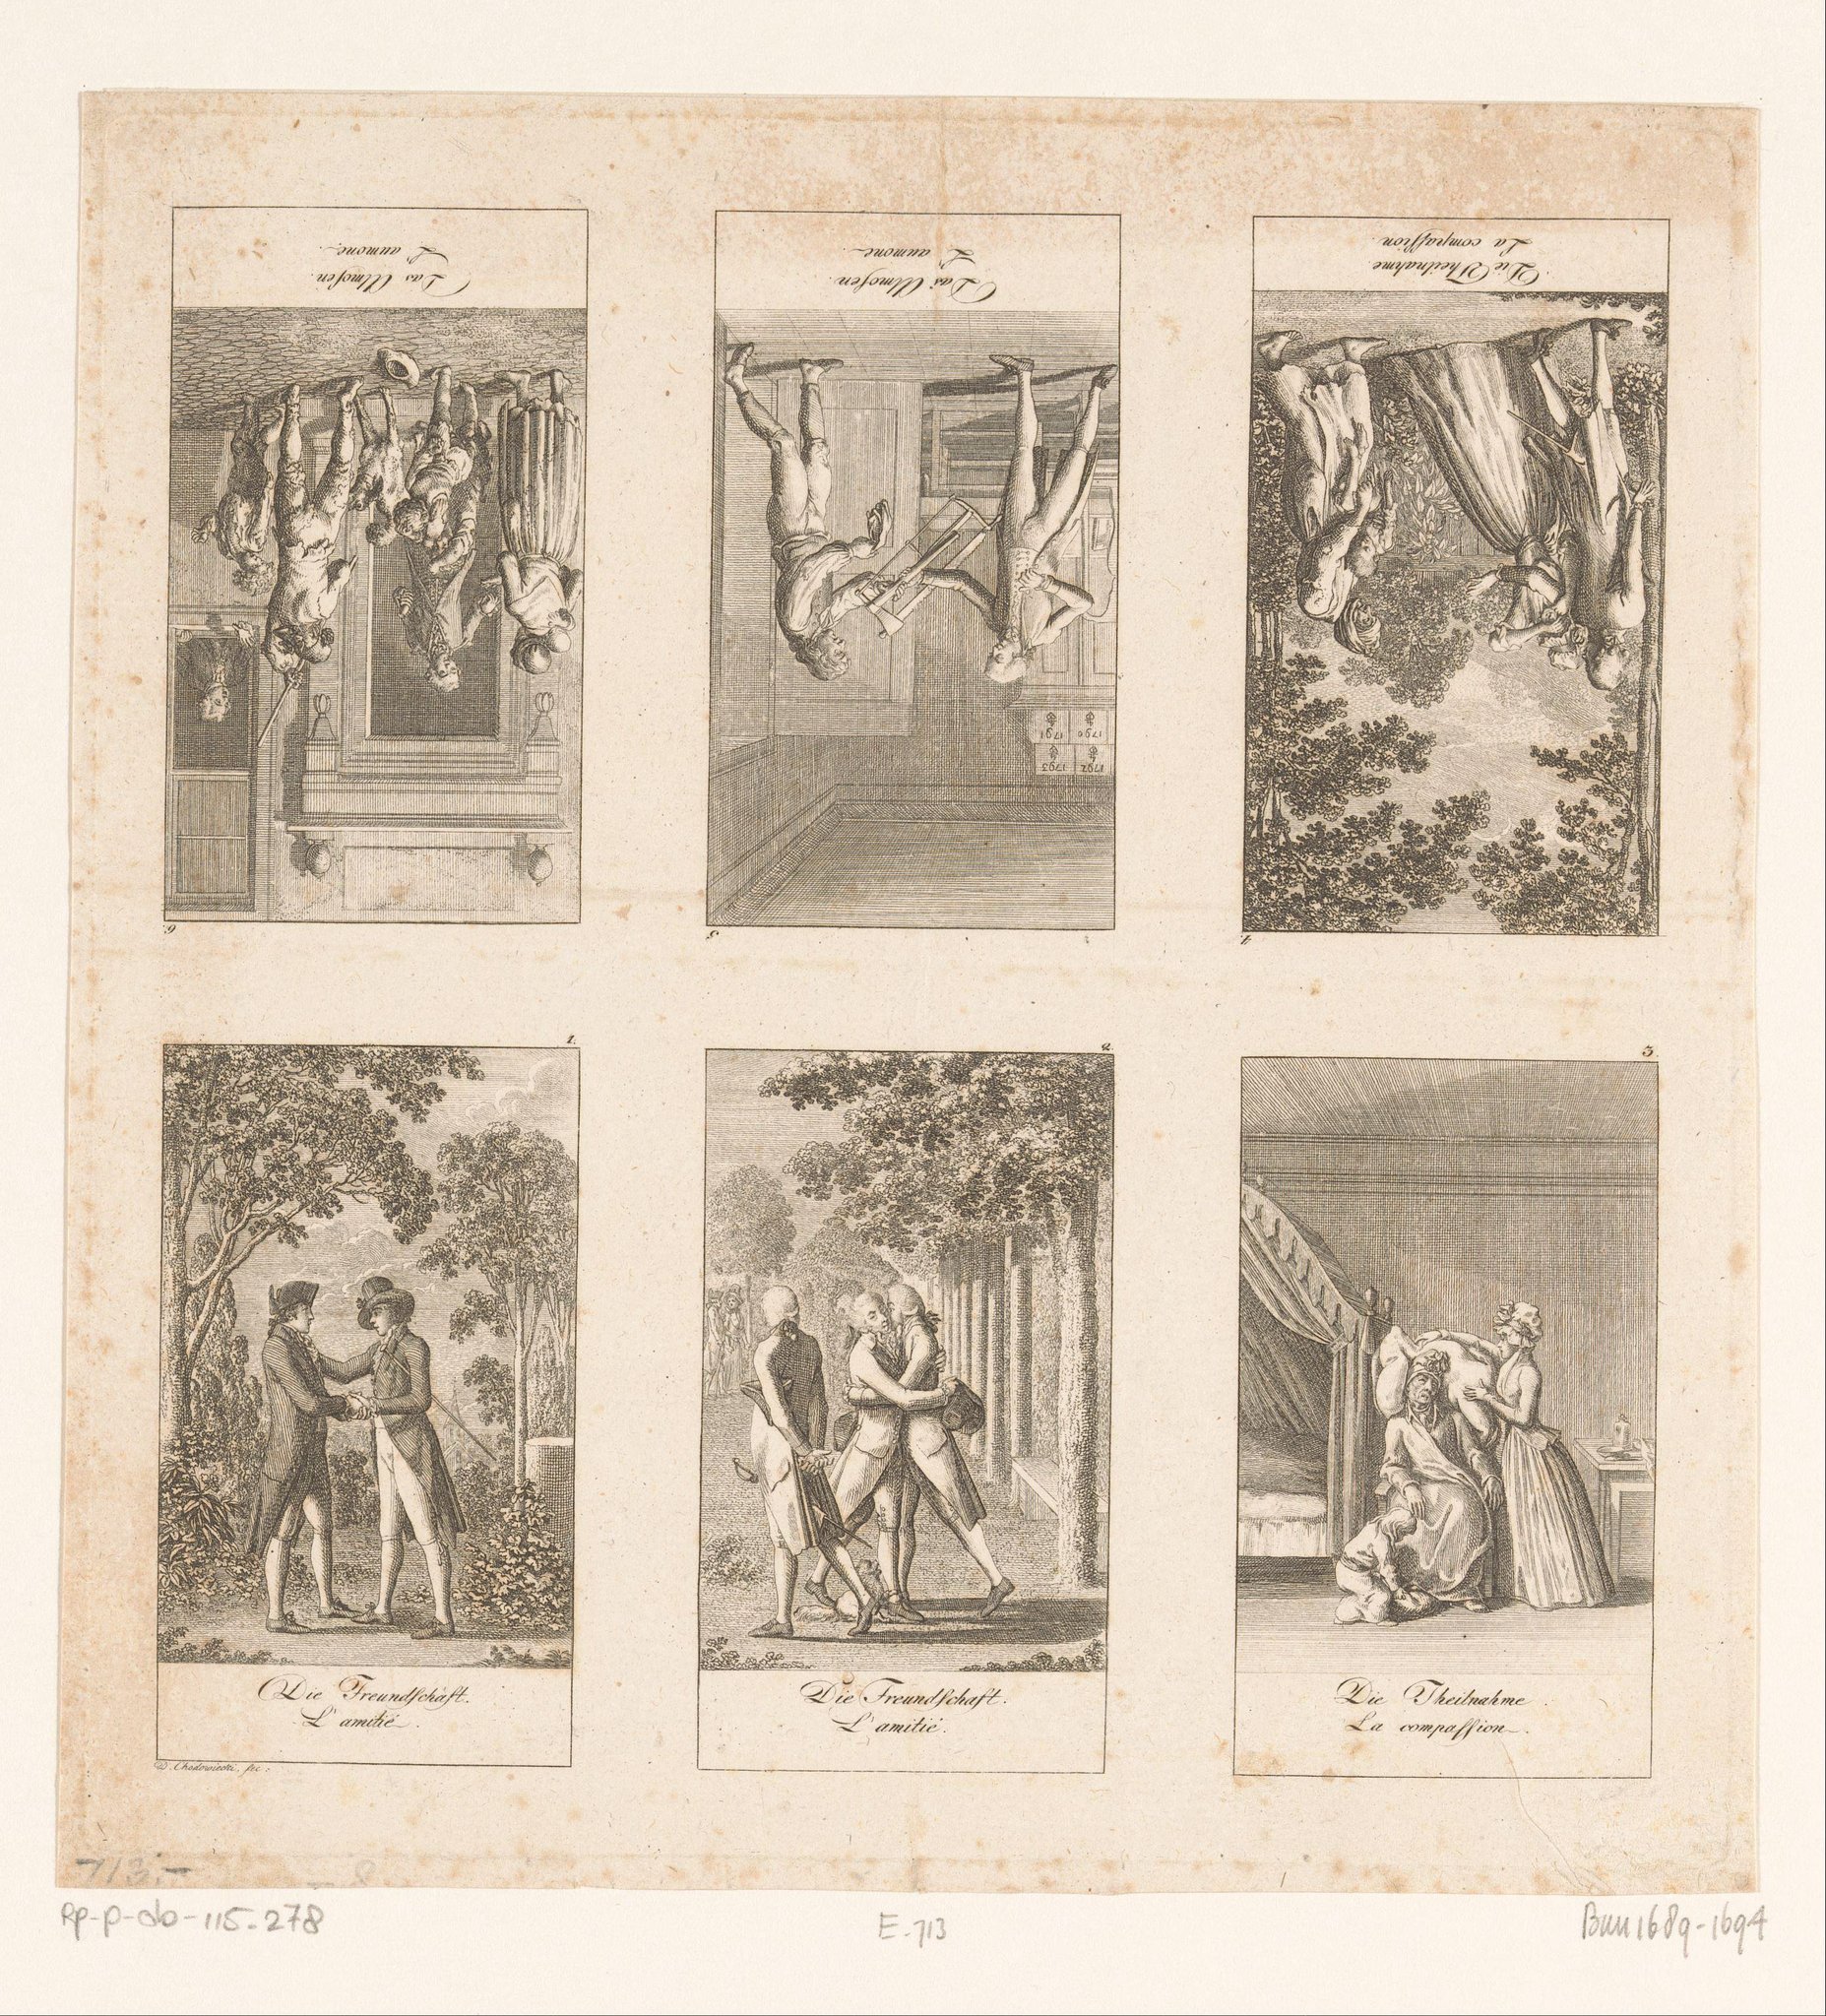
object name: print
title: Zes voorstellingen over oprechtheid en hypocrisie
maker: daniel nikolaus chodowiecki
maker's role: draughtsman, print maker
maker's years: 1726-1801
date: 1793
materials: paper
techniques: etching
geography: berlin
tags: giving alms or other charity, e.g.: handing out food, charity, 'caritas'; 'carità' (ripa) ~ one of the three theological virtues, helpfulness, sincerity; 'purità et sincerità d'animo', 'sincerità' (ripa), friendship; 'amicitia' (ripa), dissimulation, hypocrisy; 'hippocresia', 'simulatione' (ripa), honesty; 'honestà' (ripa), dishonesty, falsety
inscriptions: collector's mark: Lugt 2228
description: Prenten gebruikt voor: Goettinger Taschen Calender für das Jahr 1794. Göttingen: Johann Christian Dieterich, [1793].